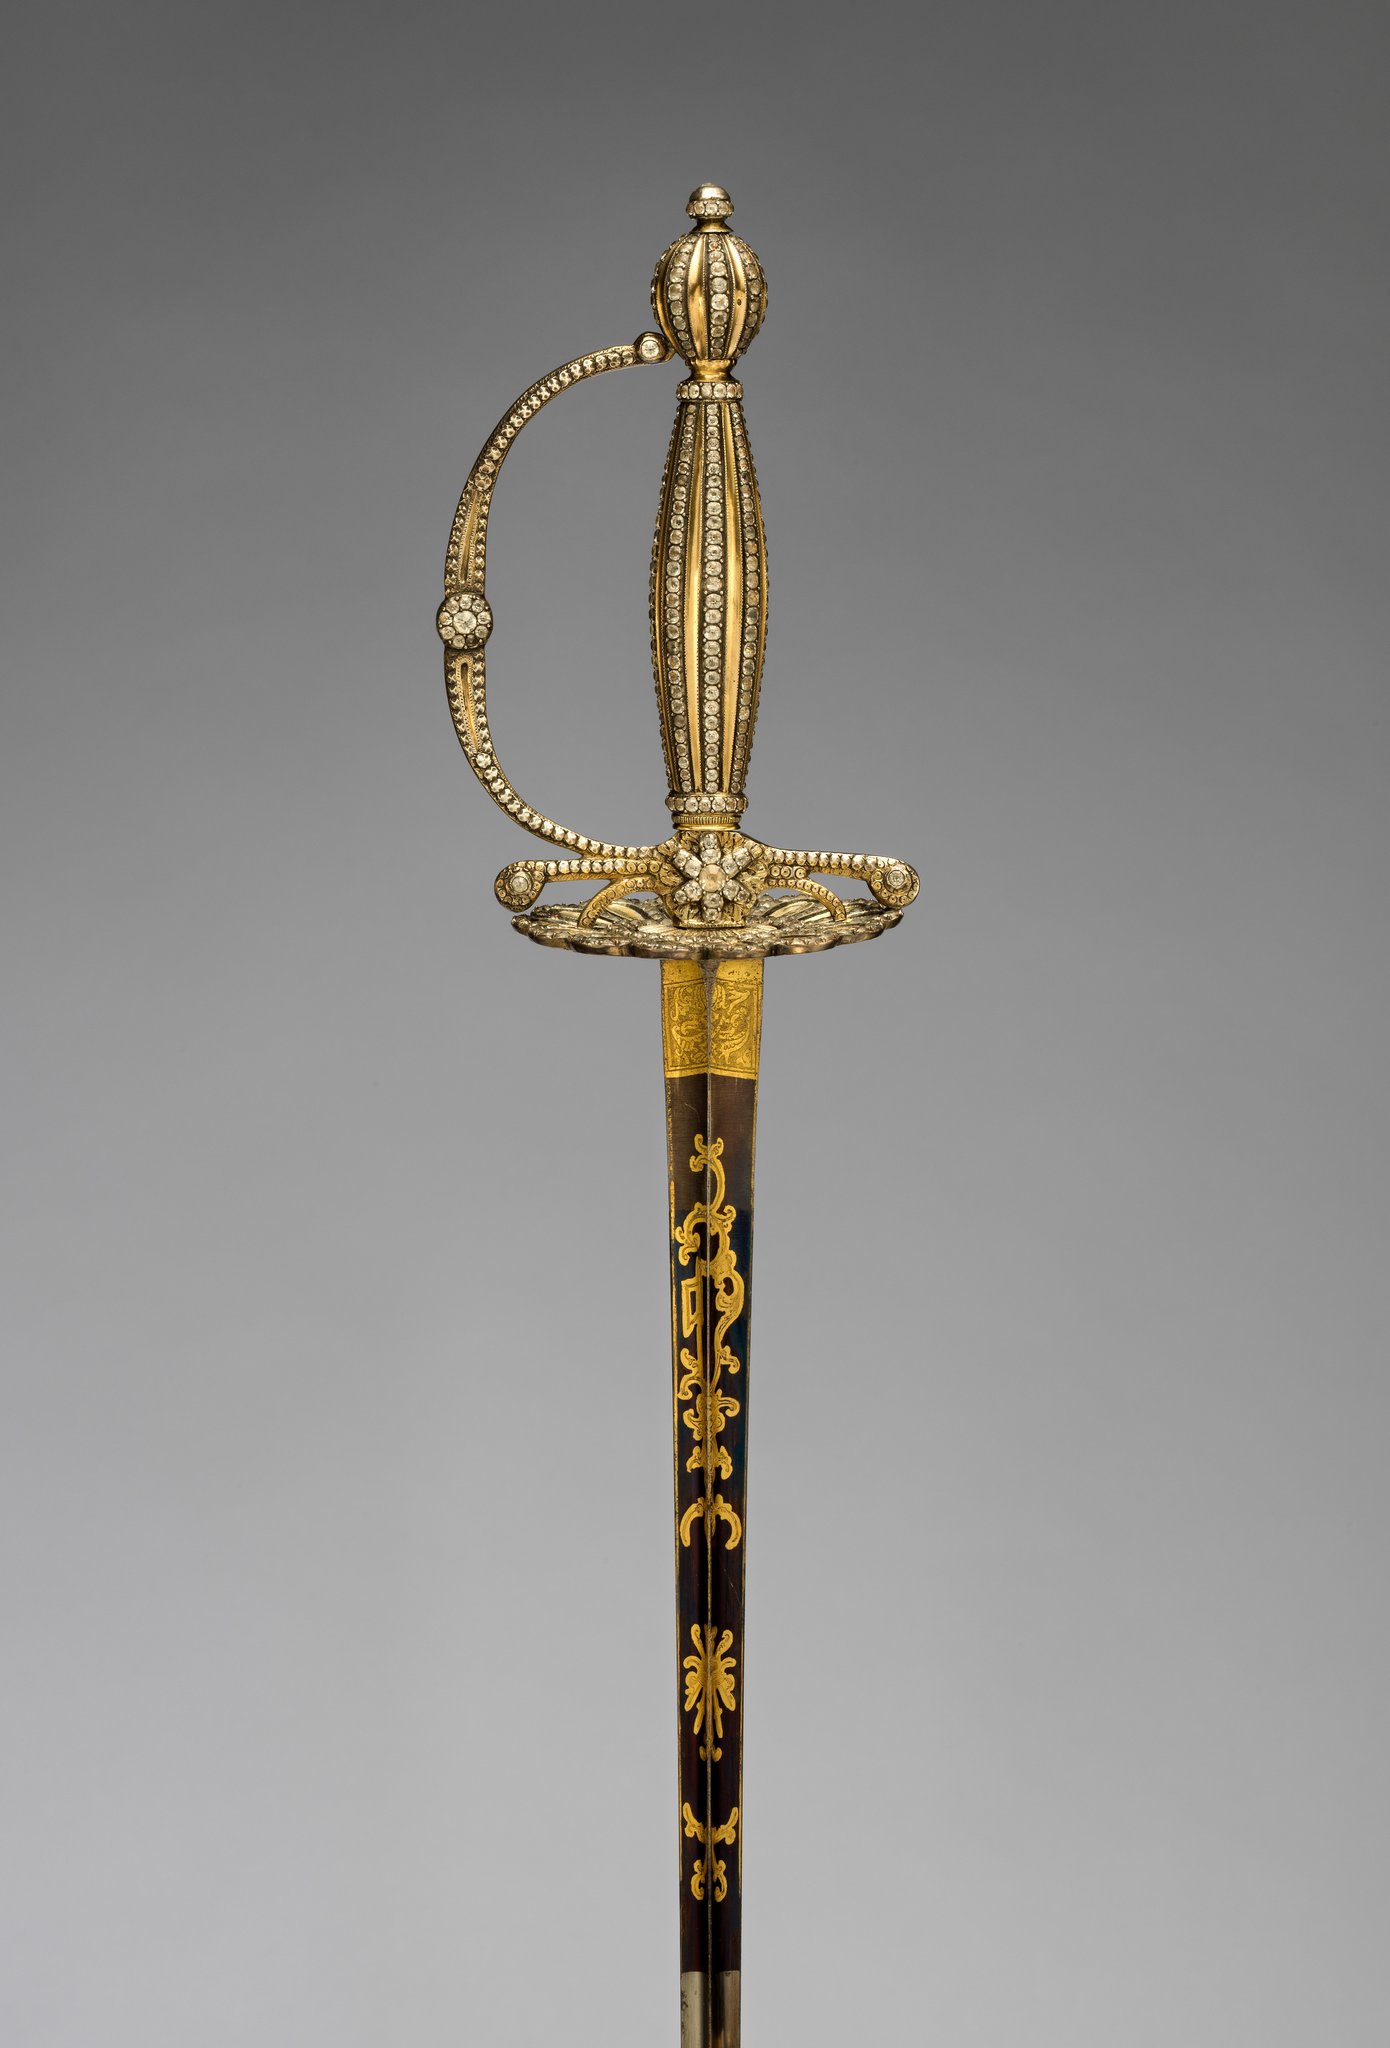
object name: smallsword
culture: french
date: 1778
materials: gold, paste, silver, steel, textile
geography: france